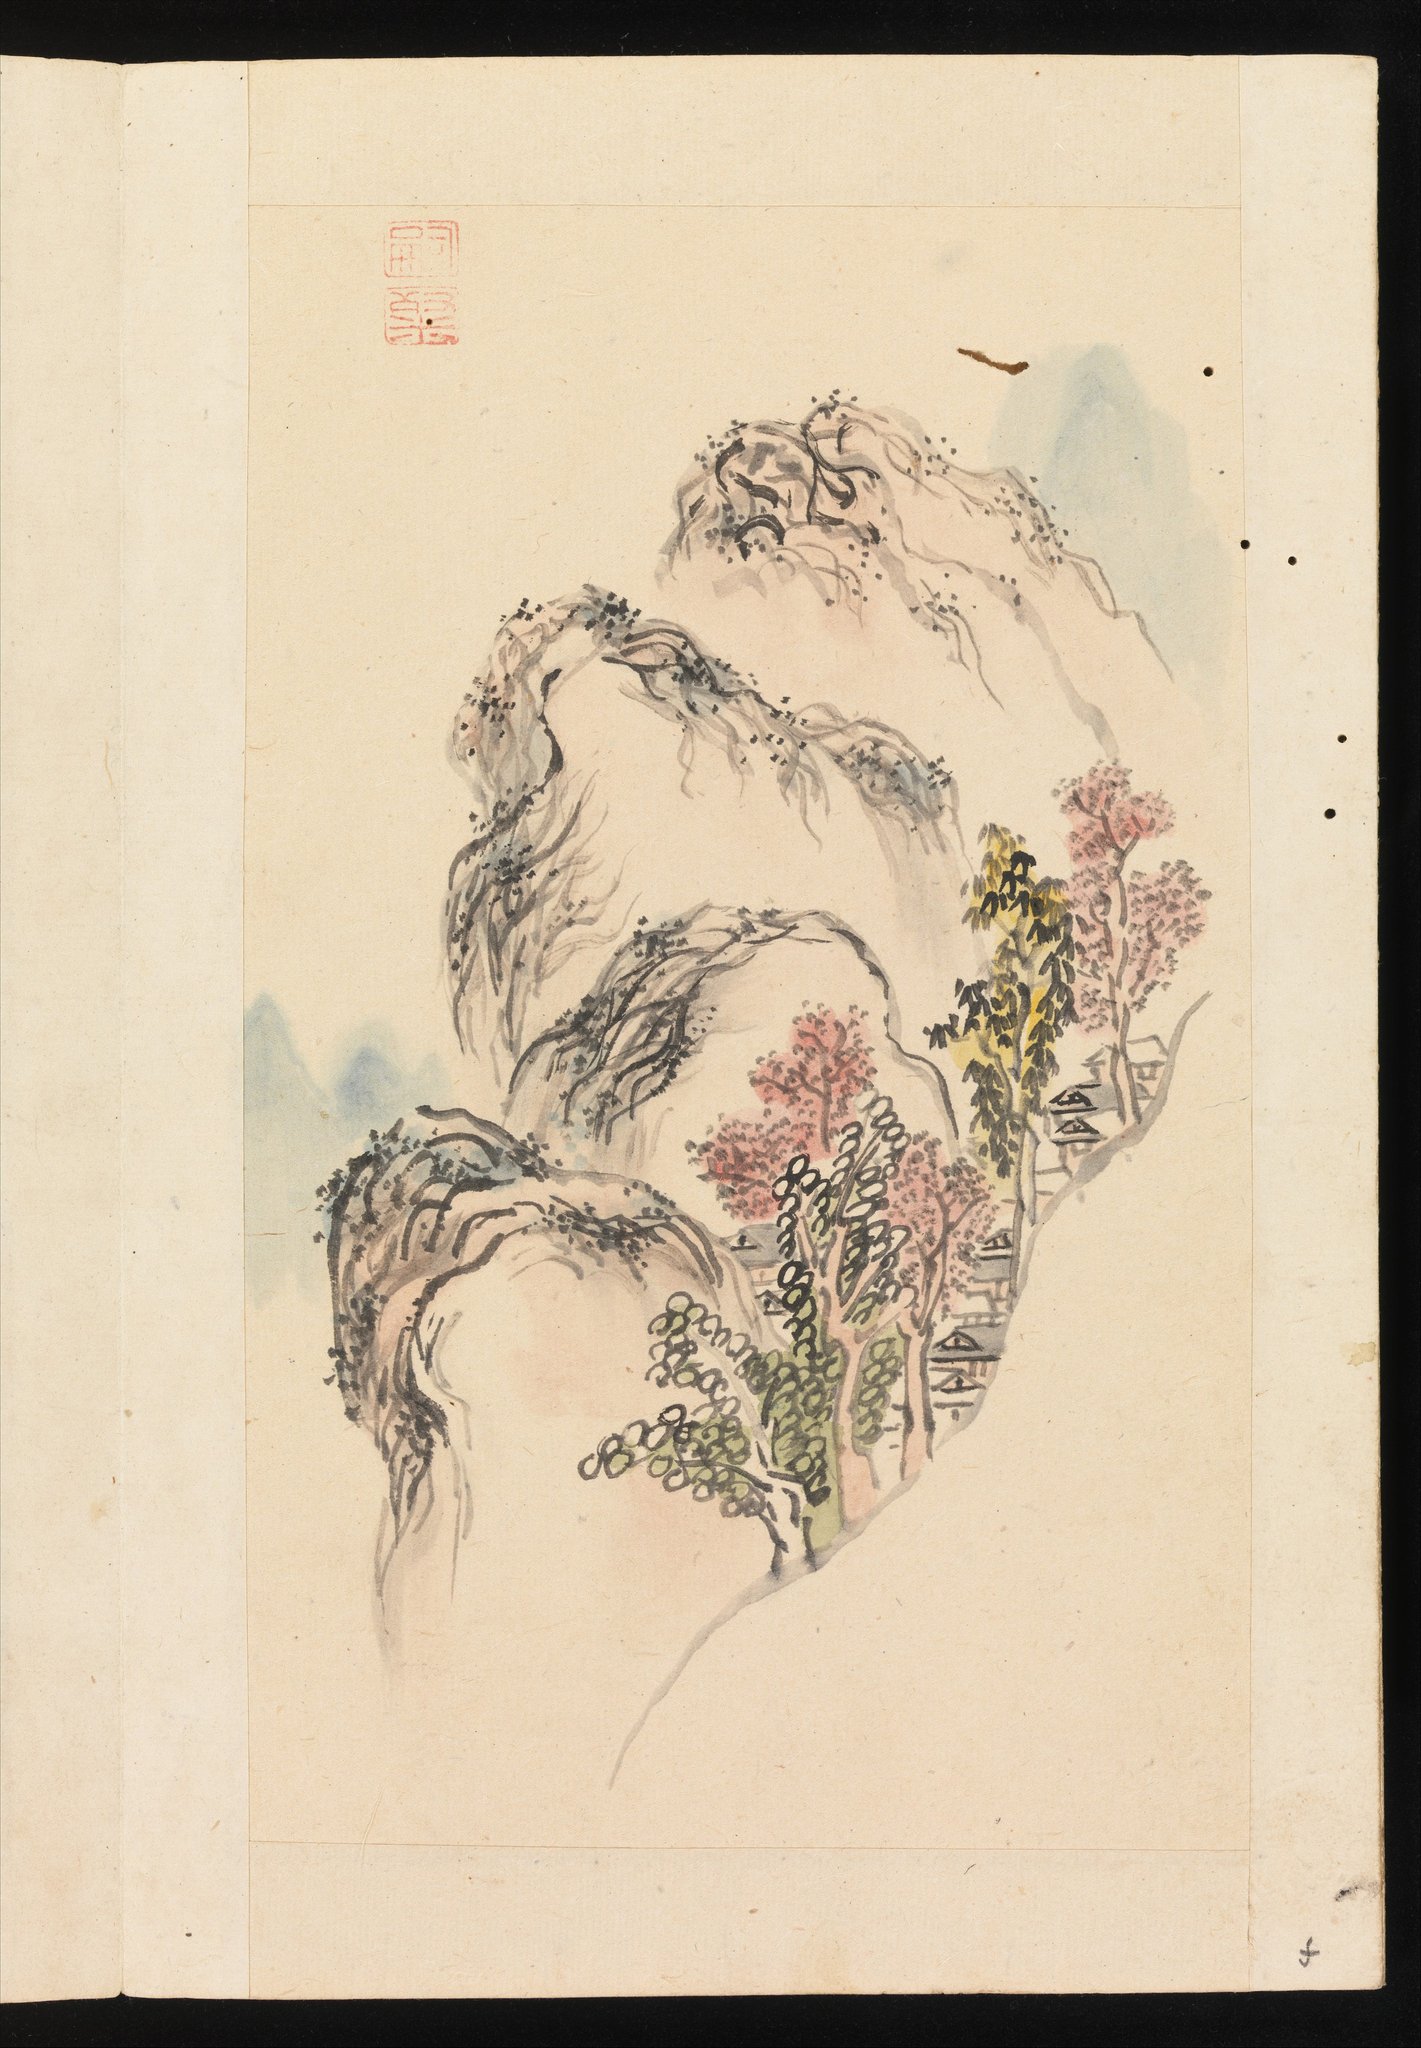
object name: album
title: Album of Landscape Paintings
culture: japanese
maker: kuwayama gyokushū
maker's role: artist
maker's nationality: japanese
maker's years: 1746-1799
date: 1767-1800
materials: ink, paper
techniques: calligraphy, painting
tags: landscapes